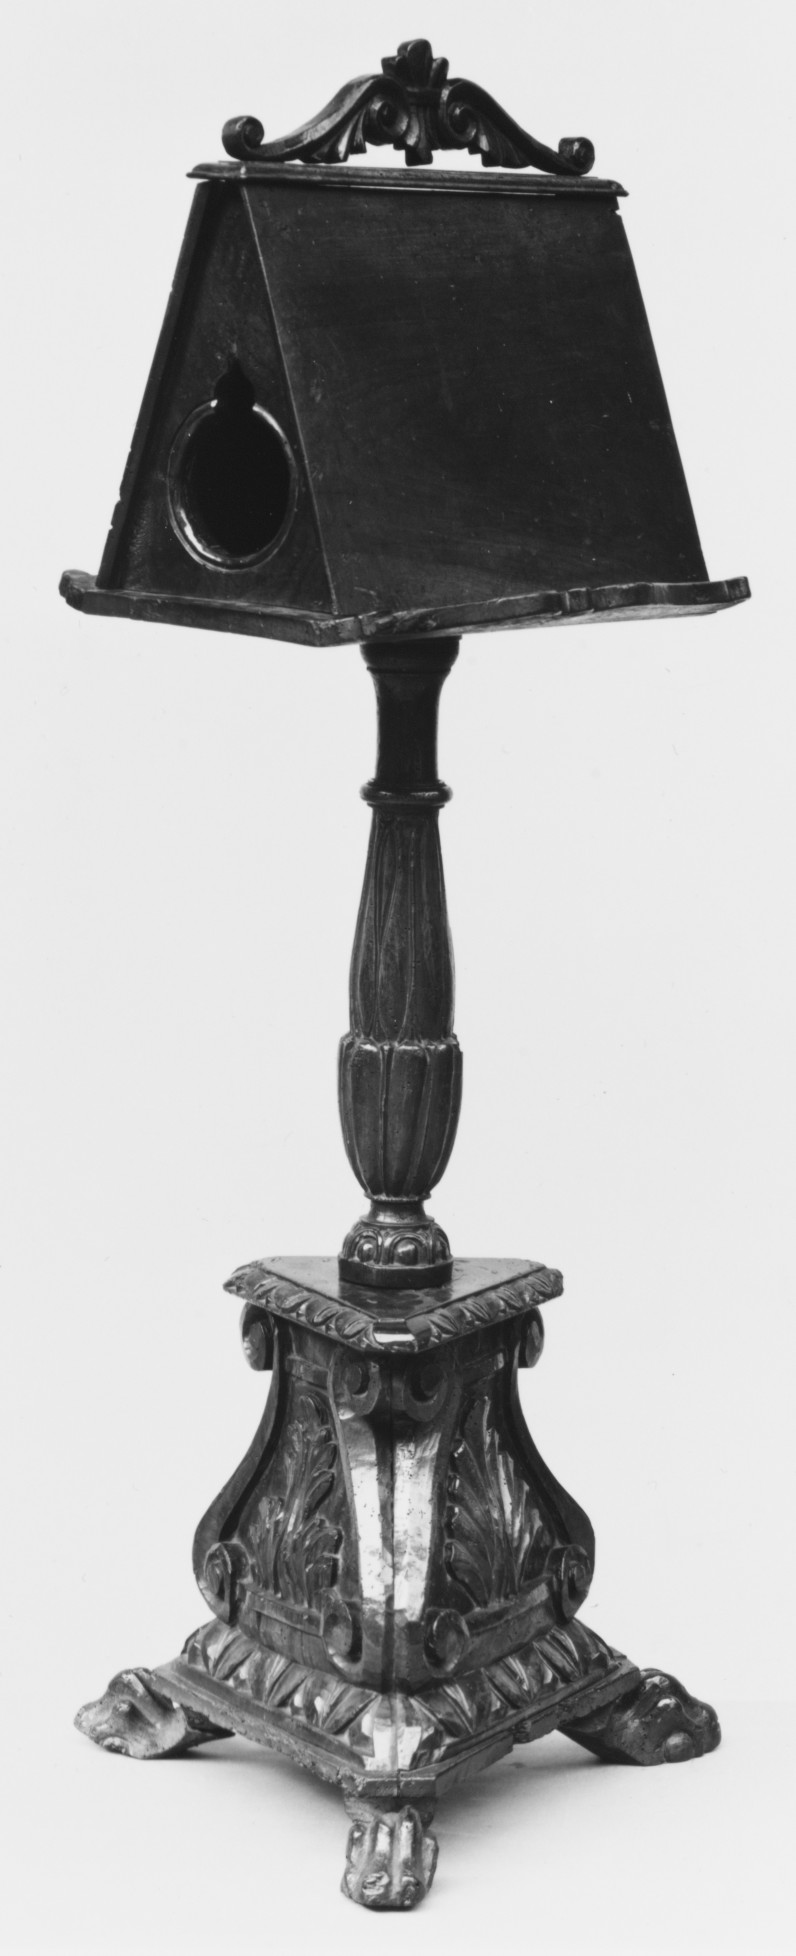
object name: lectern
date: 1501-1600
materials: wood